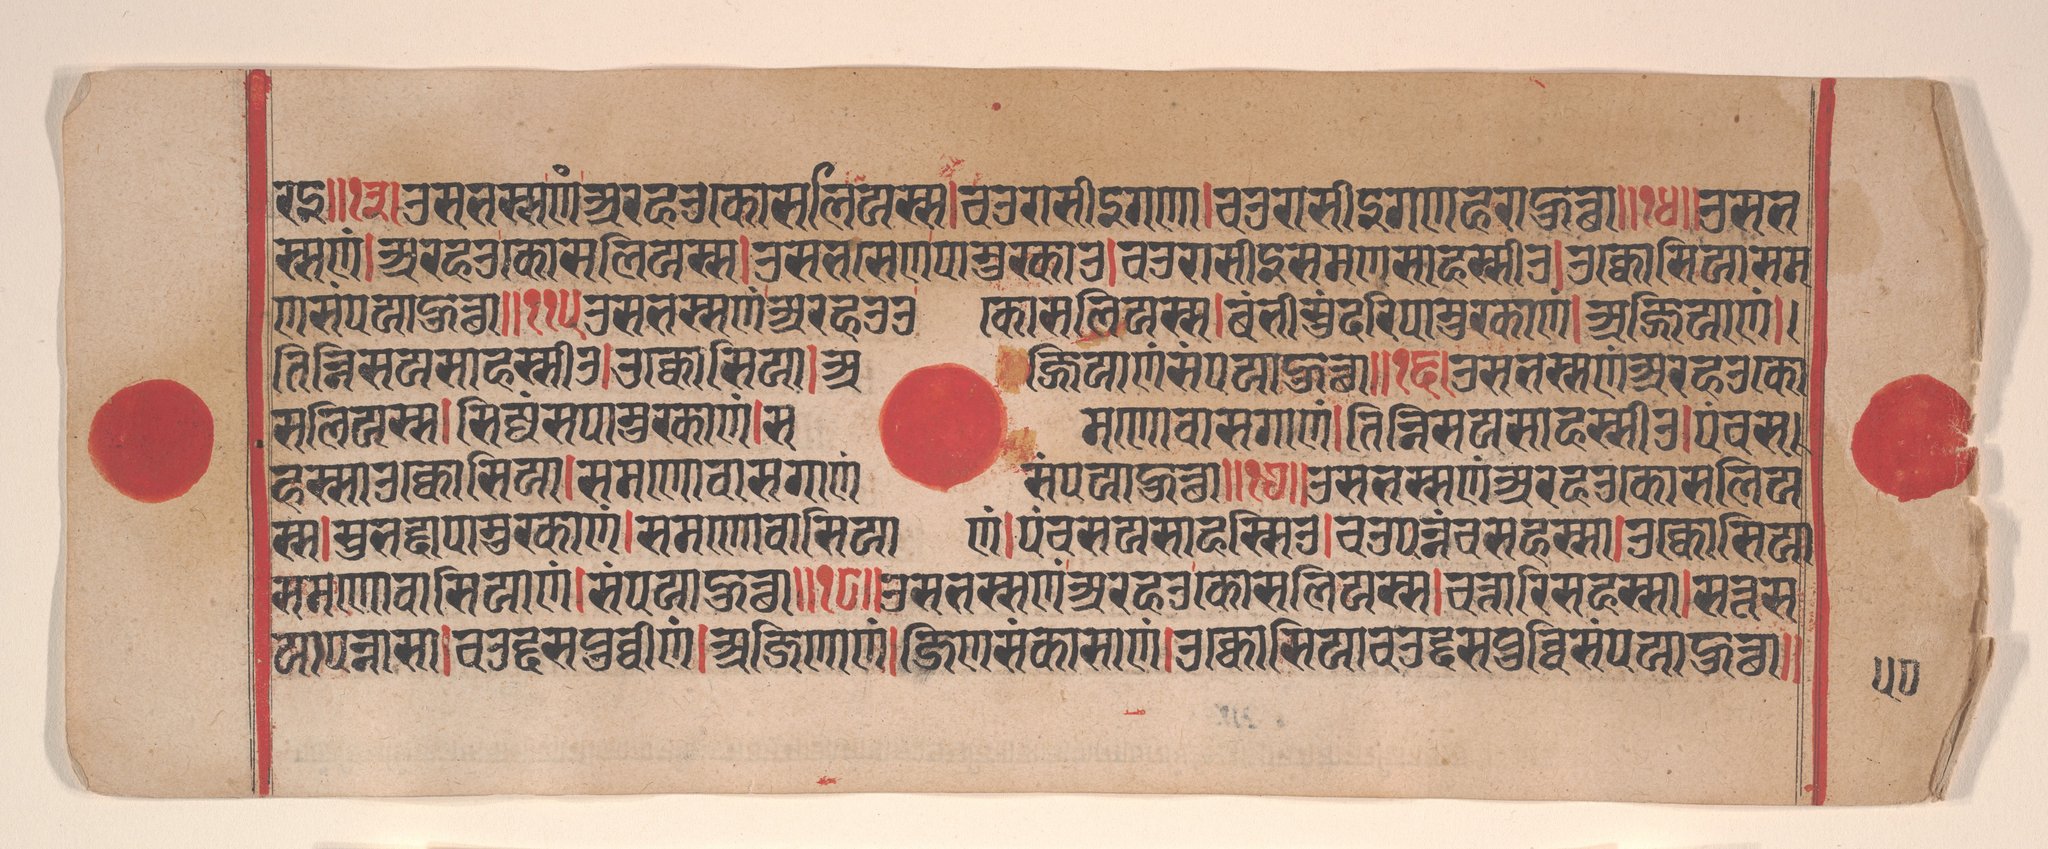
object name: folio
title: Leaf from a Kalpa Sutra (Jain Book of Rituals)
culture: indian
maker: bhadrabahu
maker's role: artist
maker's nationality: indian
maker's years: 356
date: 1401-1500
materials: gold, ink, paper, watercolor